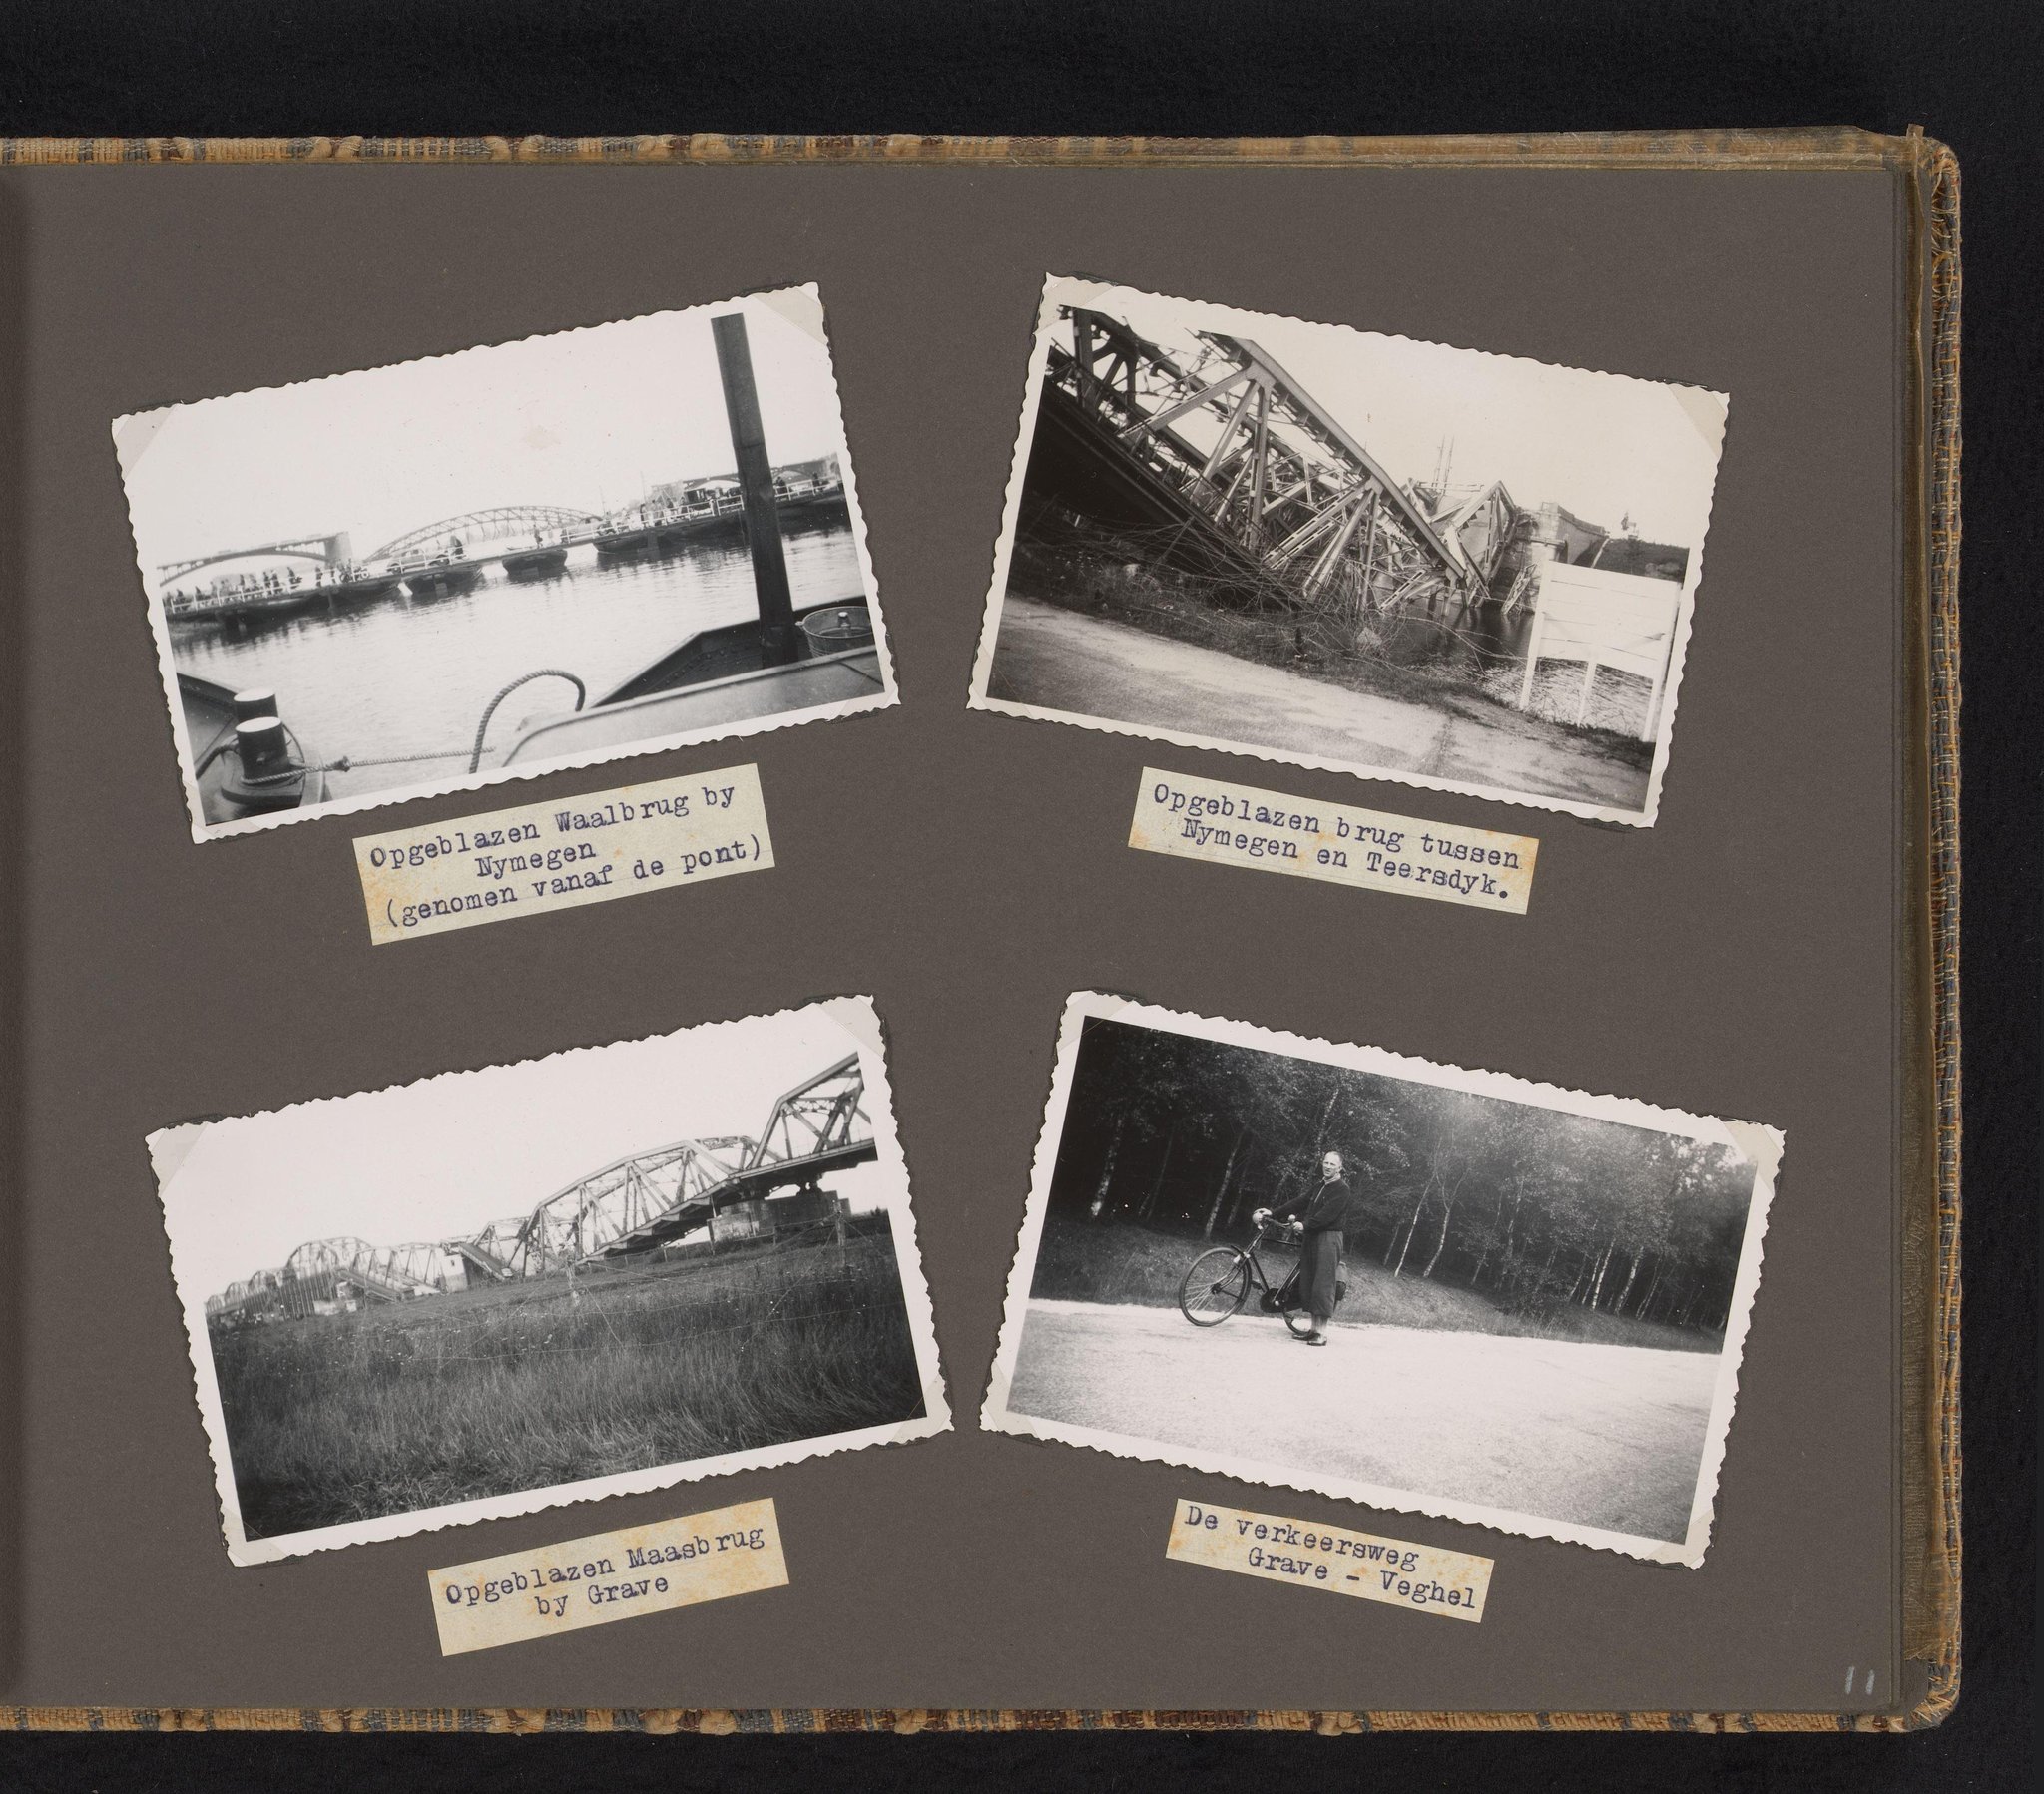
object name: photograph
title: Opgeblazen bruggen over de Waal en Maas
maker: Anonymous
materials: paper, photographic support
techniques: gelatin silver print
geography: netherlands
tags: riding, cycling (recreation), father with son(s) (father-love), outing, pleasure trip, bicycle, devastated, ruined place or city (~ warfare), nijmegen, grave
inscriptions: inscription: ‘Opgeblazen Waalbrug by Nymegen (genomen vanaf de pont) / Opgeblazen brug tussen Nymegen en Teersdyk / Opgeblazen Maasbrug by Grave / De verkeersweg Grave - Veghel’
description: Albumblad met vier foto's van oorlogsverwoestingen en opgeblazen bruggen over de Waal en Maas bij Nijmegen en Grave en één foto van de vader met fiets. Onder de foto's uitgeknipte papiertjes met getypte opschriften. Onderdeel van het eerste fotoalbum met foto's van de twee fietstochten van vader en zoon door Nederland in september 1939 en juli 1940 en een autotrip met het gezin door Nederland, België en Luxemburg in juni 1949.